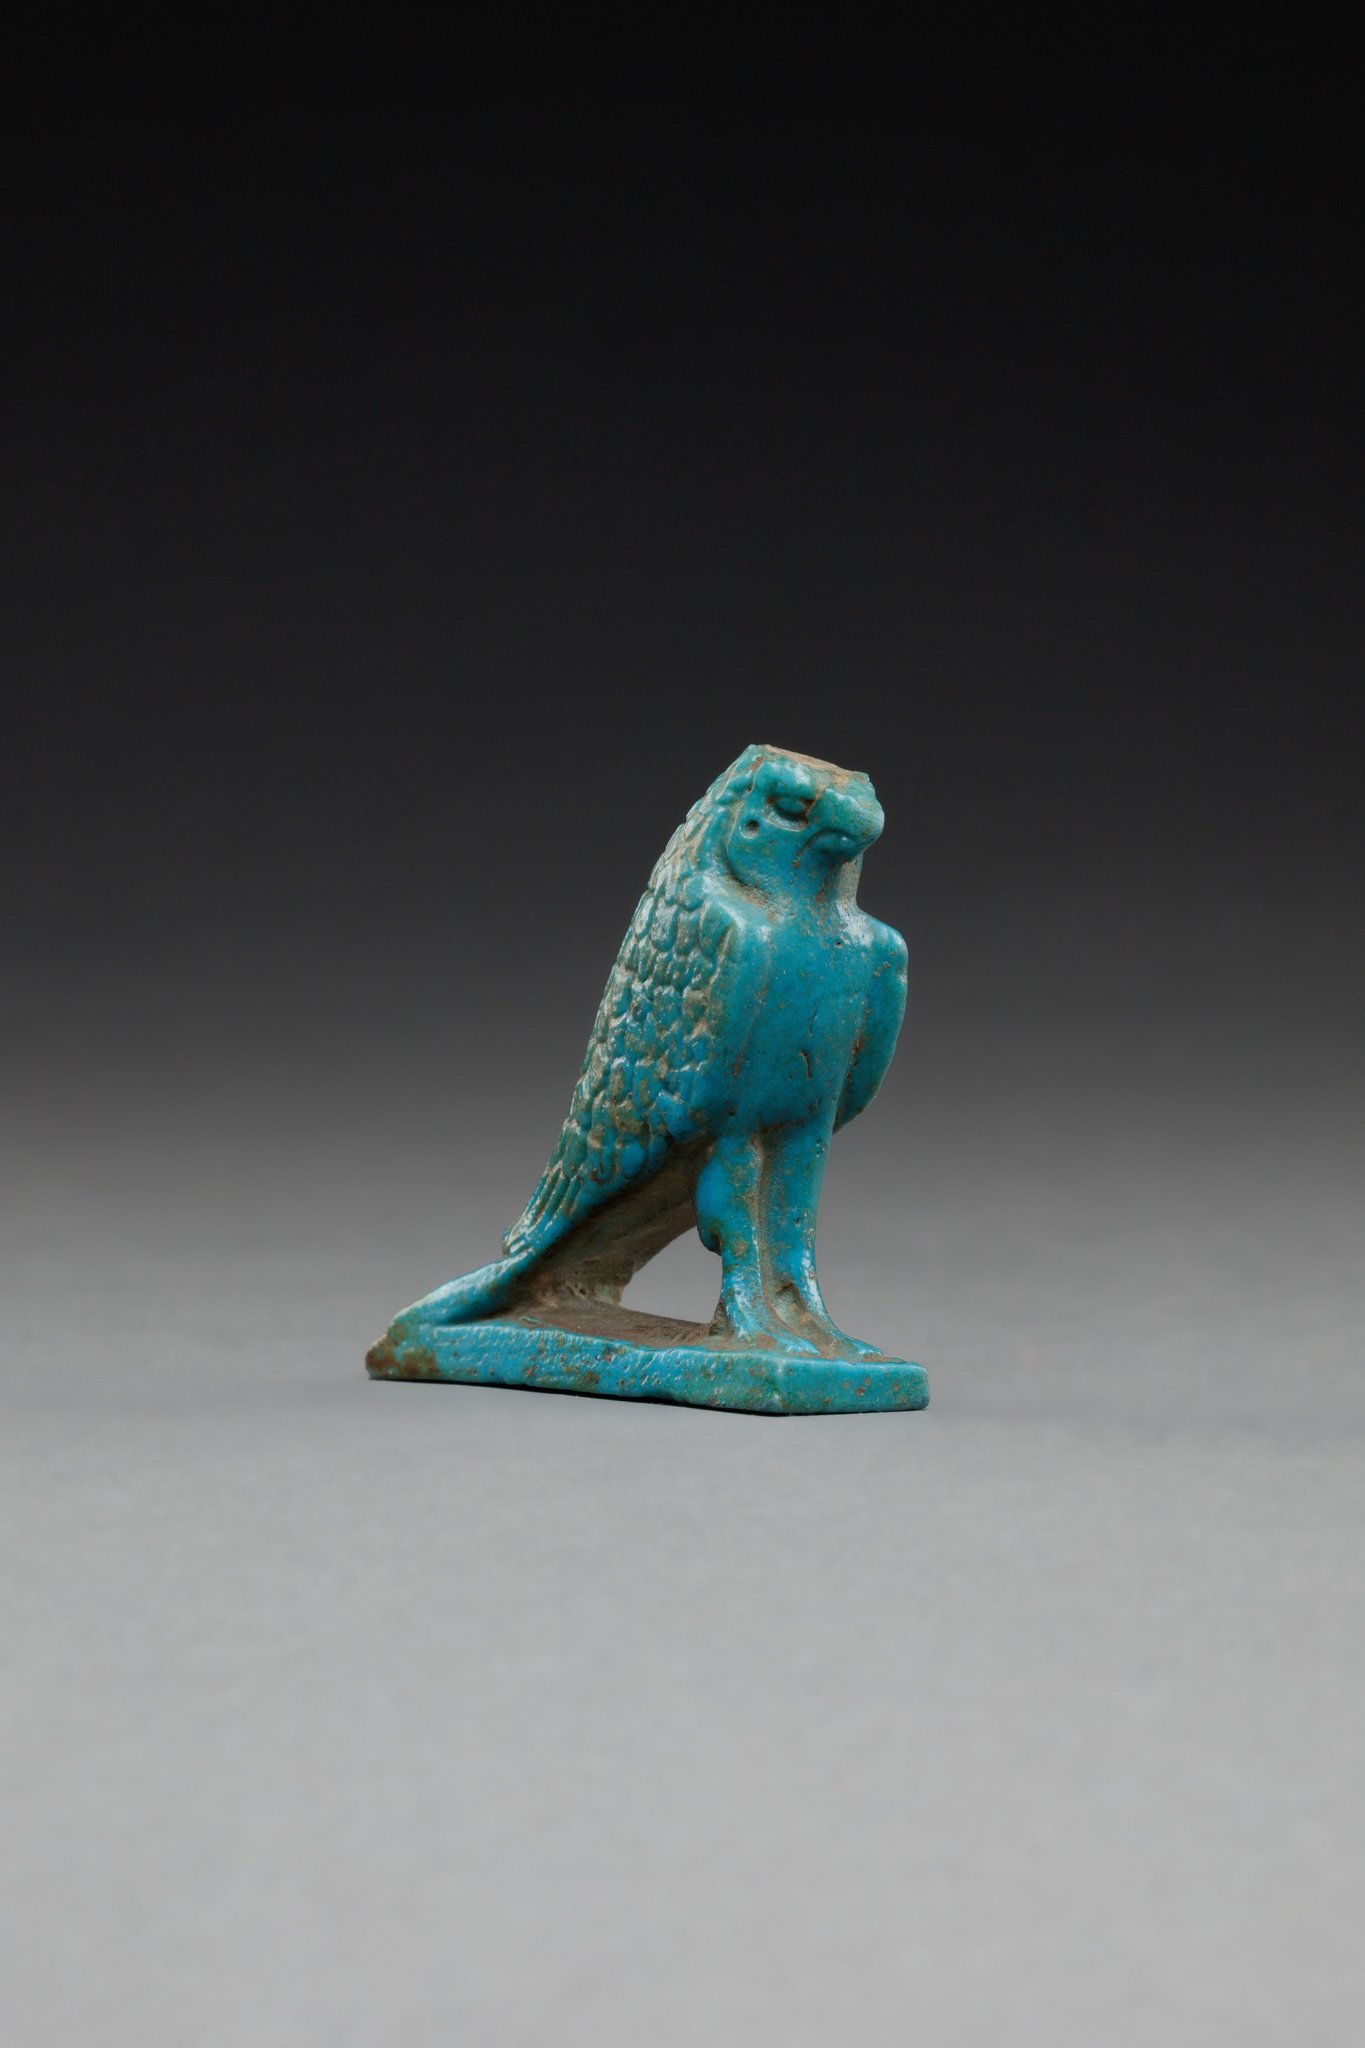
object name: amulet, falcon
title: Falcon Amulet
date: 664-630 BCE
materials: faience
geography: egypt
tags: falcons